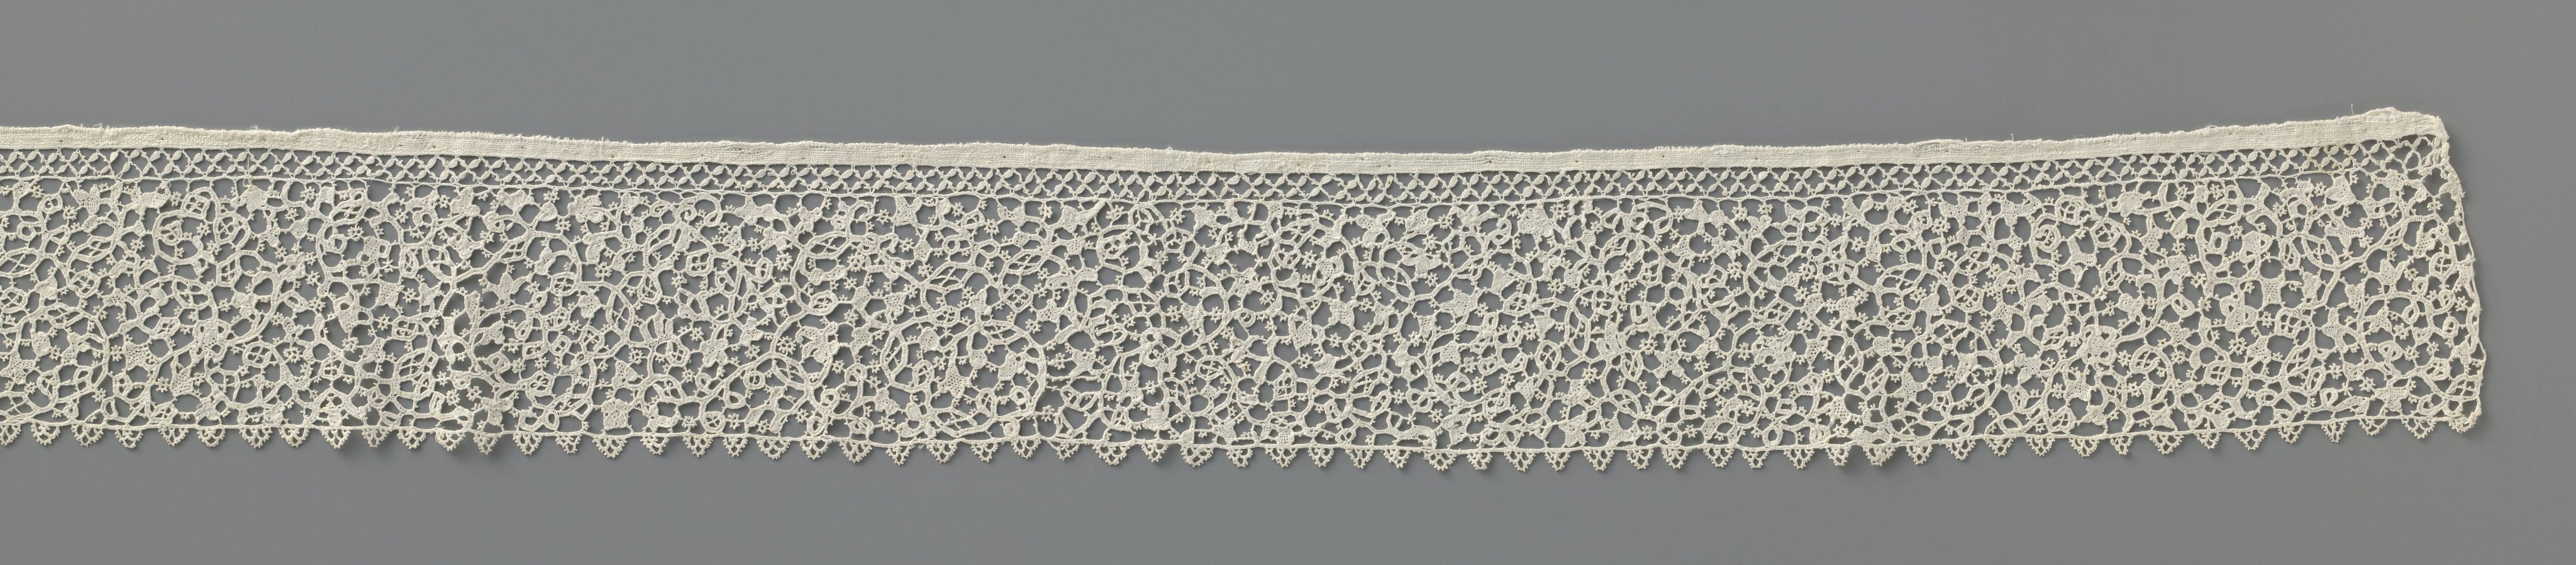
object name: strip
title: Strook naaldkant met serpentines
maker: Anonymous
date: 1675-1699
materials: linen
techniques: flat venetian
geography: venice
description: Strook naturelkleurige naaldkant: platte Venetiaanse kant. Onregelmatige open spijlengrond van korte, met radertjes-picots bezette spijltjes. Dunne elkaar kruisende spiraalrankjes vormen een lopend patroon van serpentines. Rechte buitenlijst van gelijke driehoekjes.